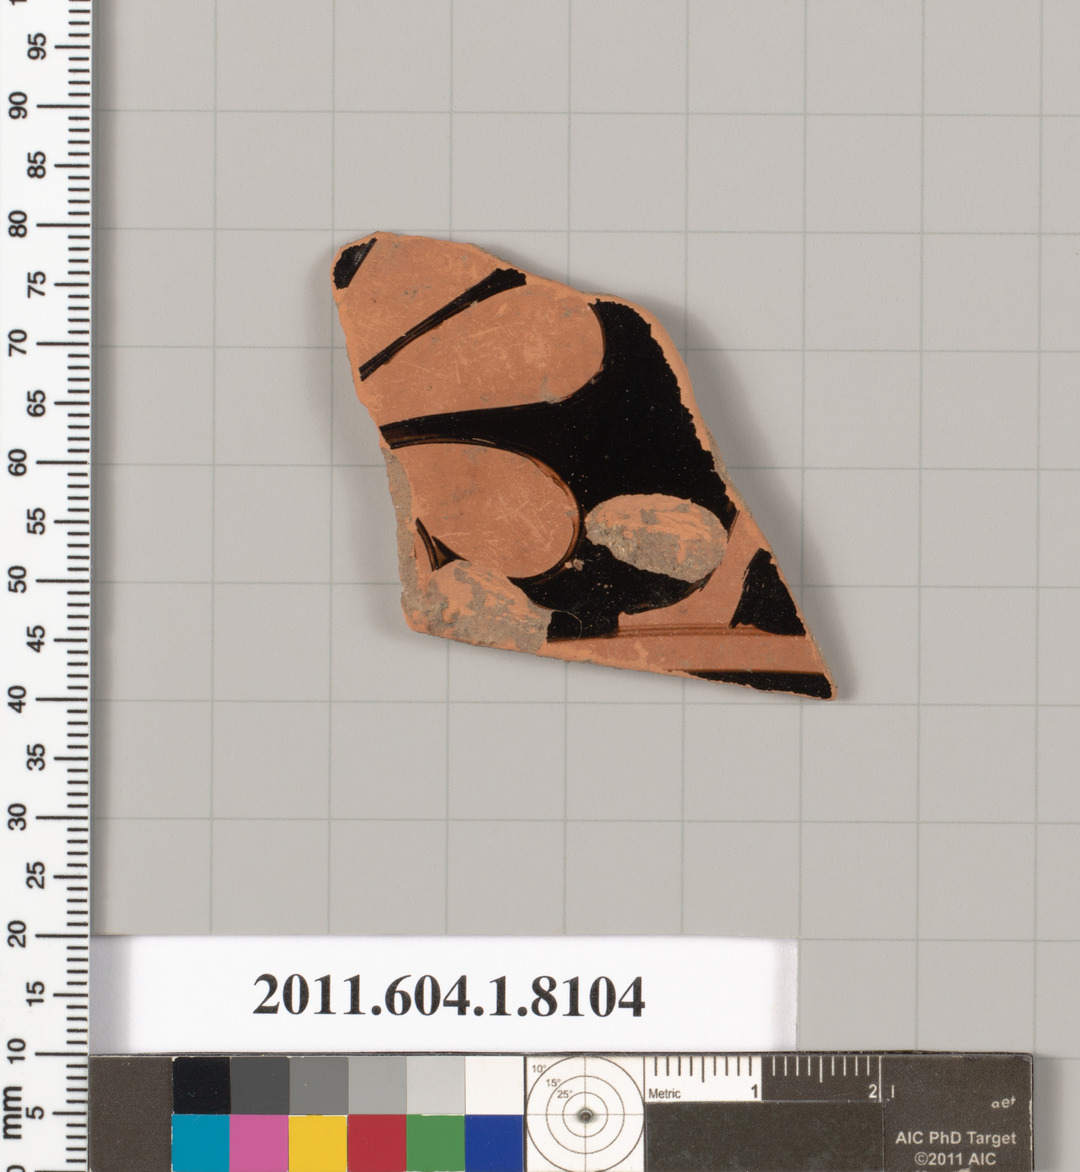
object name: kylix fragment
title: Terracotta fragment of a kylix (drinking cup)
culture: greek, attic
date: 520-510 BCE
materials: terracotta